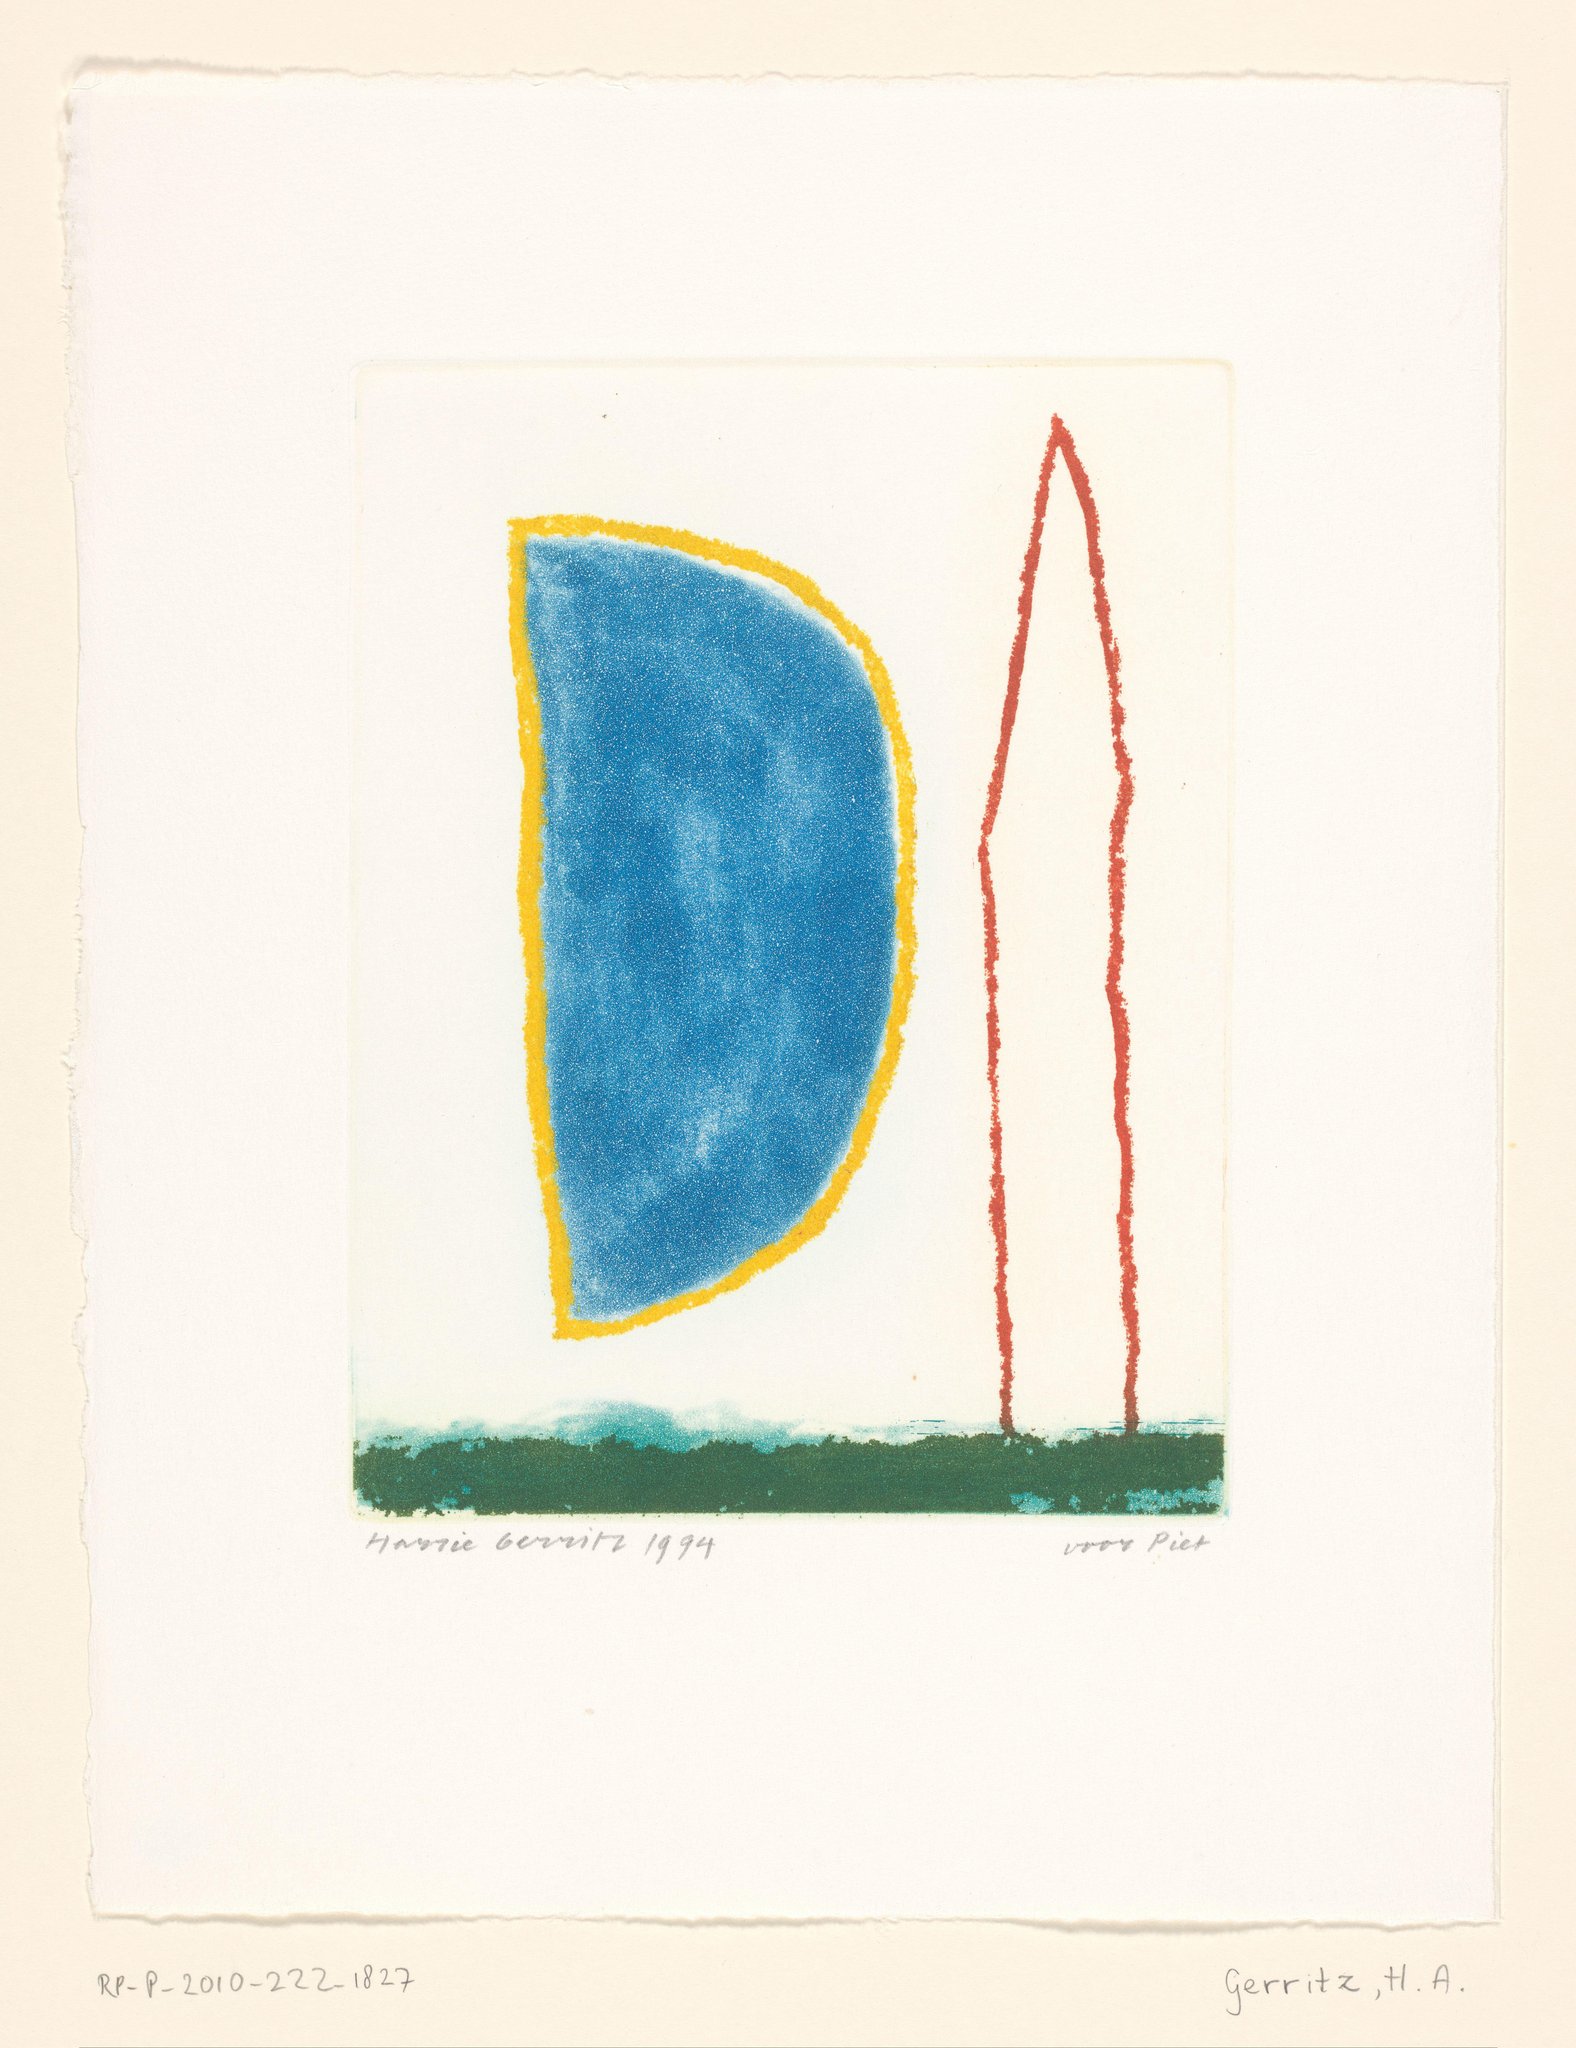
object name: print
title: Rode toren, halfronde blauwe cirkel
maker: harrie a. gerritz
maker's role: draughtsman, painter, print maker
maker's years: 1940-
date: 1994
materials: paper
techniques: aquatint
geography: amsterdam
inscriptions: signature and date: ‘Harrie Gerritz 1994’